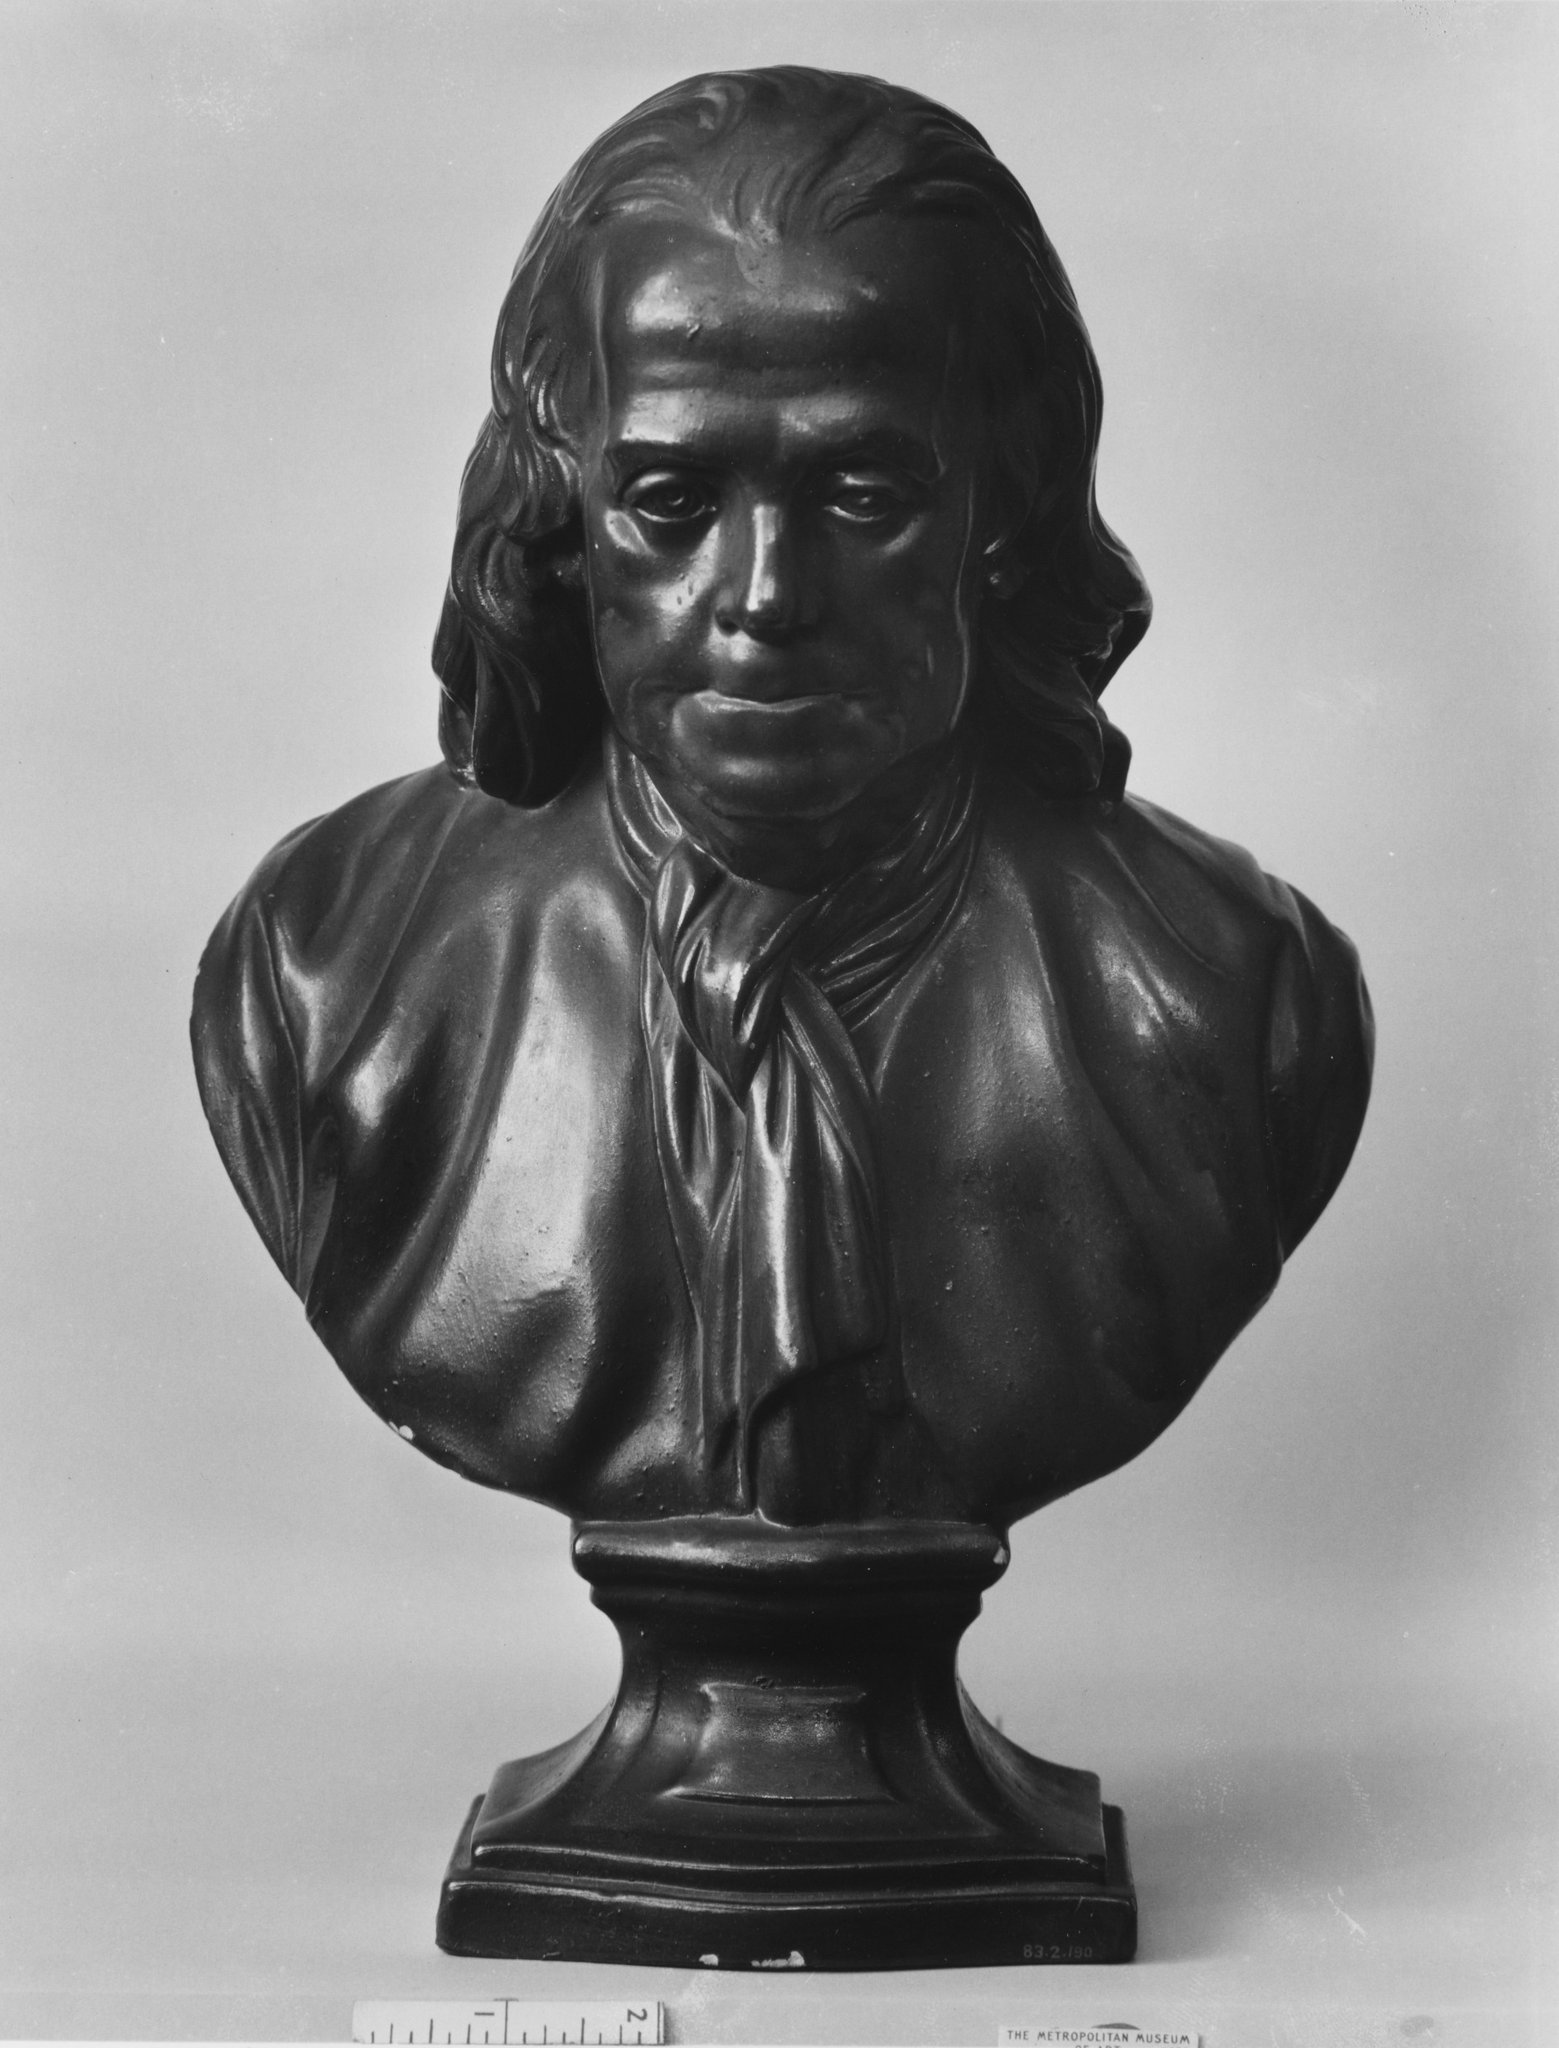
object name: bust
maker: jean jacques caffiéri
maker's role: artist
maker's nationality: french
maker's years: 1725-1792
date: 1815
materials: plaster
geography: england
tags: benjamin franklin,men,portraits